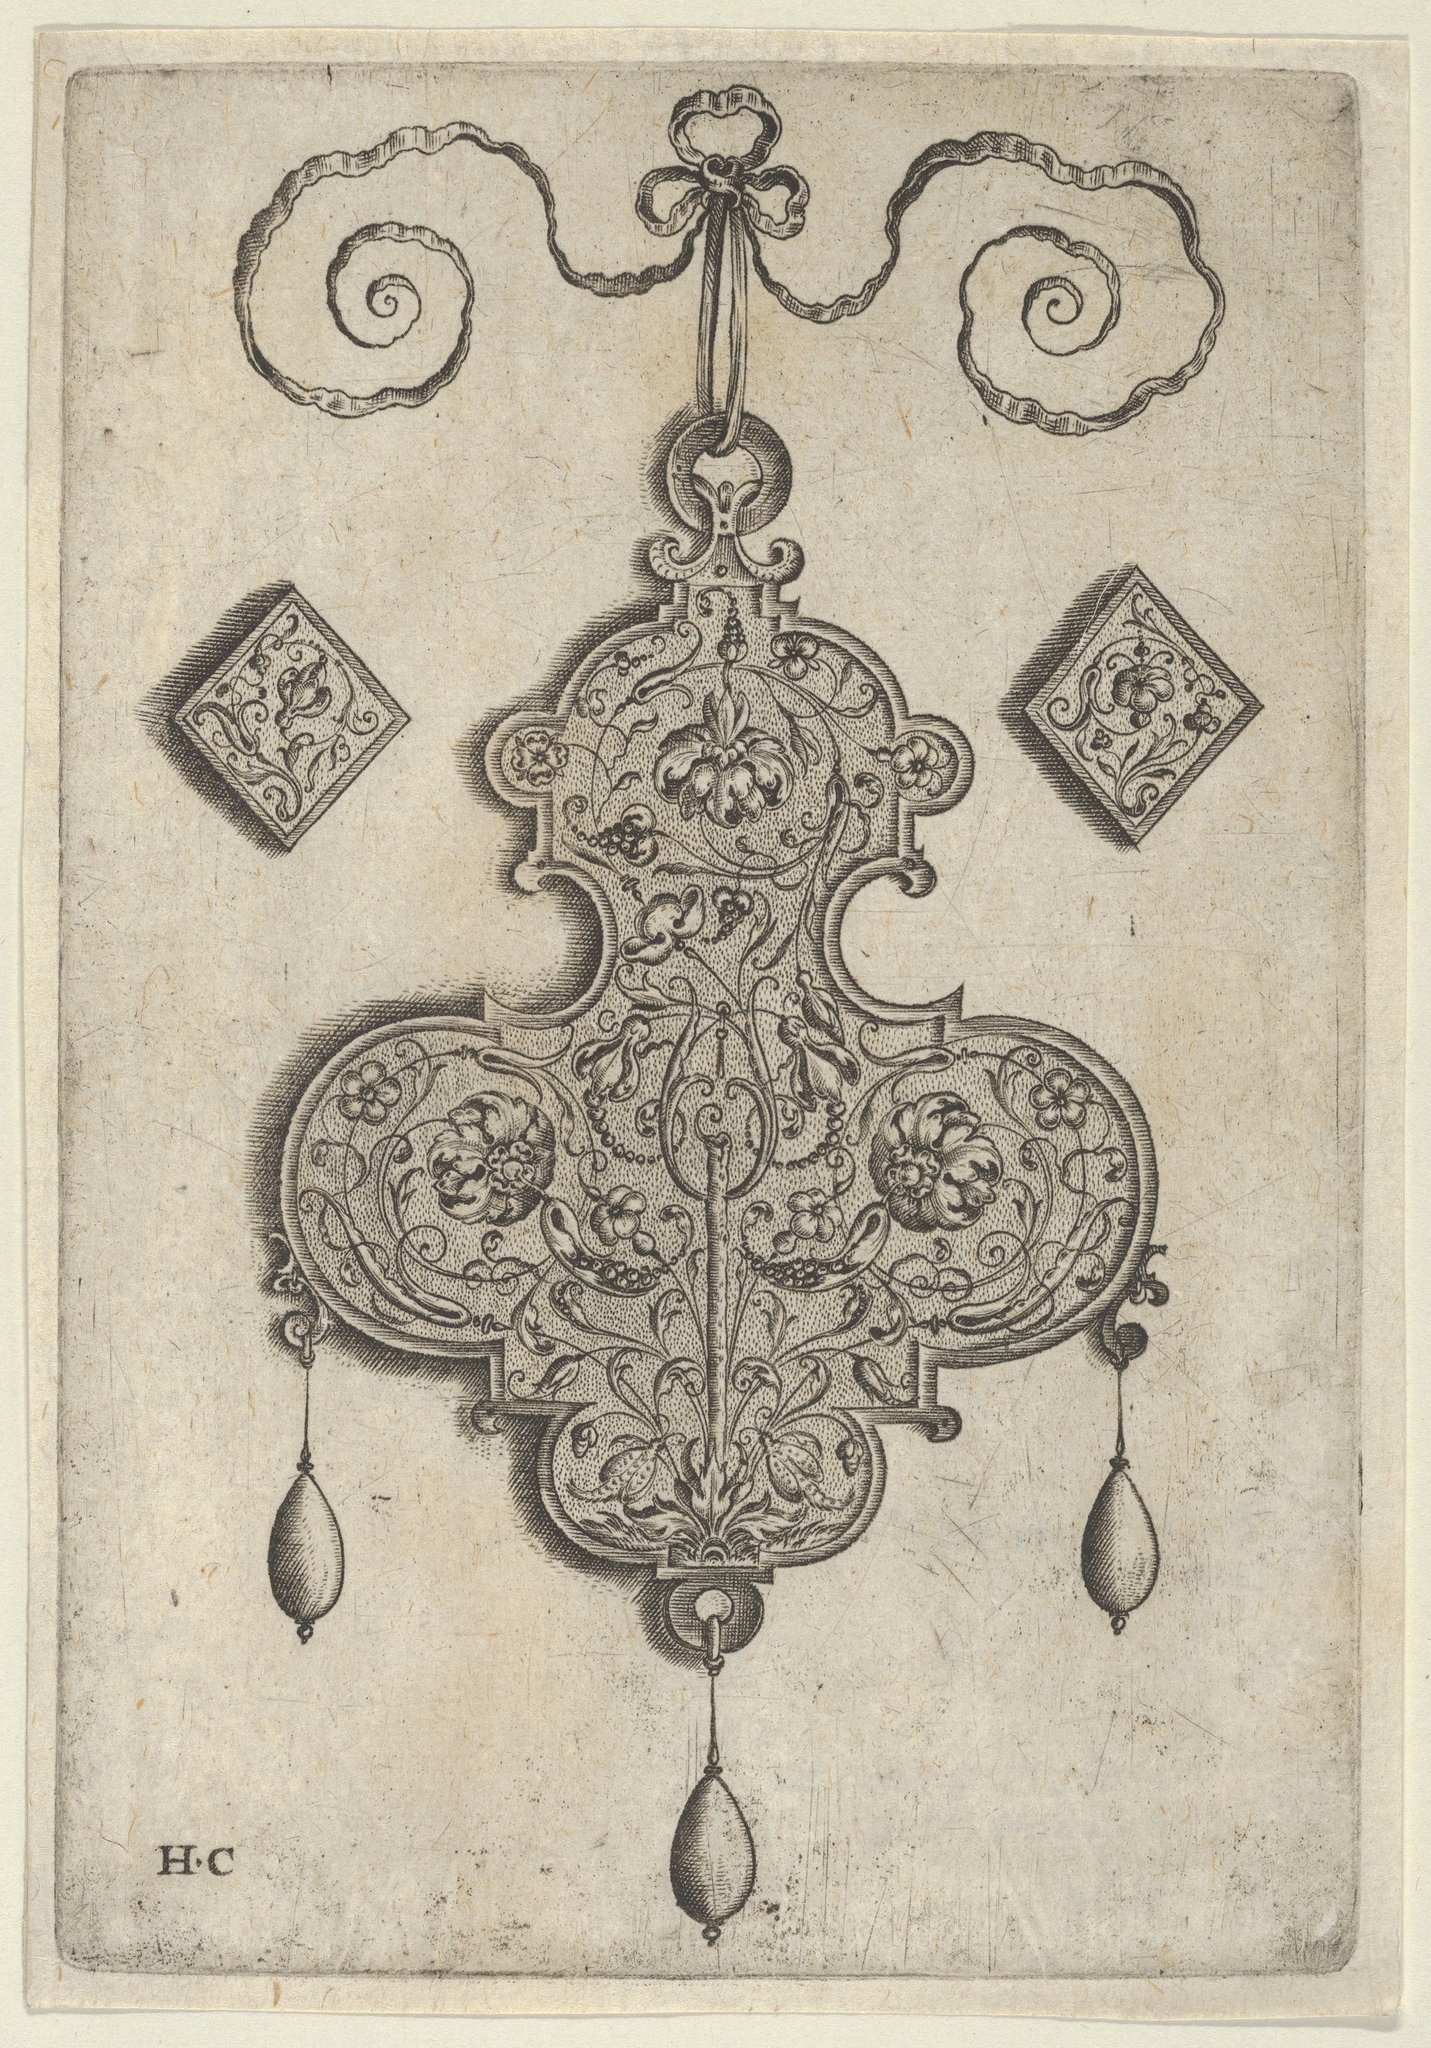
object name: print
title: Design for the Verso of a Pendant with Three Large Flowers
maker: jan collaert i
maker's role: artist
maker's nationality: netherlandish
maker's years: 1530-1581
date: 1573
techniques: engraving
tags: pendants,flowers